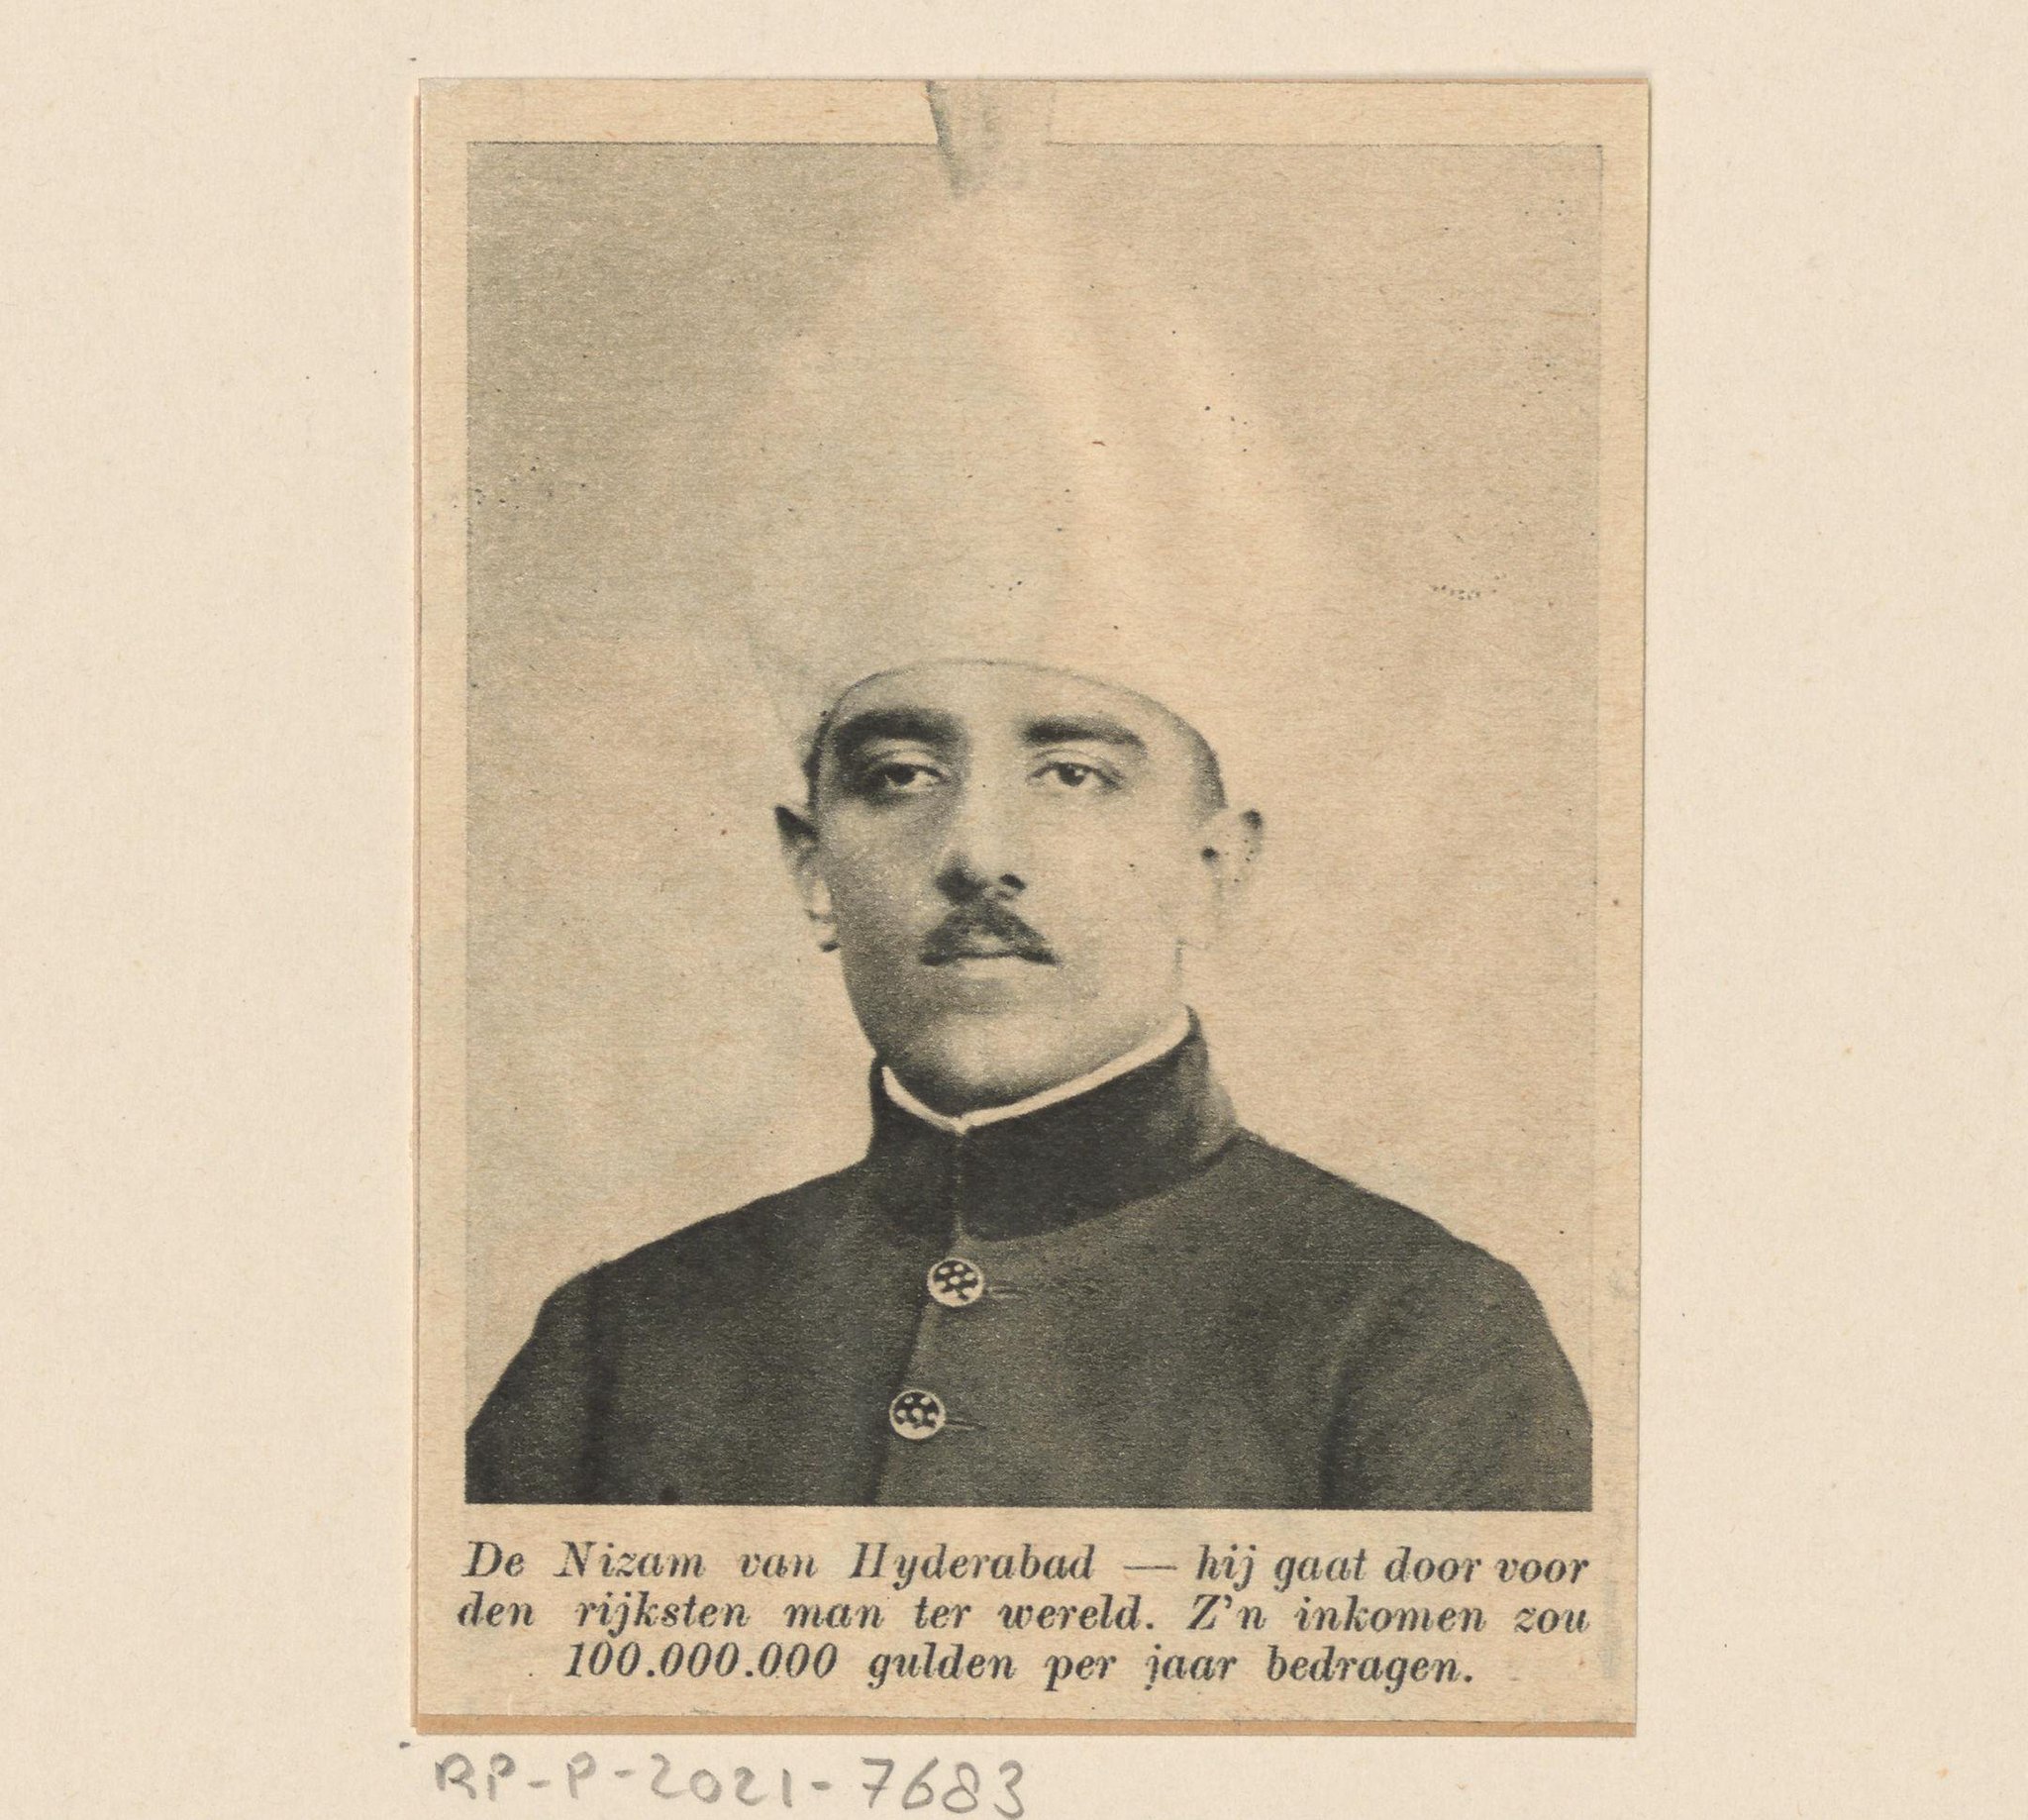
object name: photomechanical print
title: Portret van Osman Ali Khan, Nizam van Hyderabad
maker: Anonymous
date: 1911-1940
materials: paper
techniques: rotogravure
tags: historical persons, ruler, sovereign